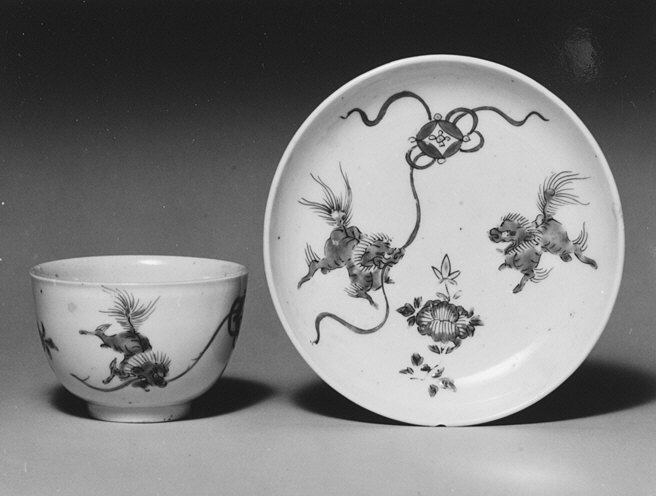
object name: teabowl and saucer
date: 1740-1770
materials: hard paste porcelain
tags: animals